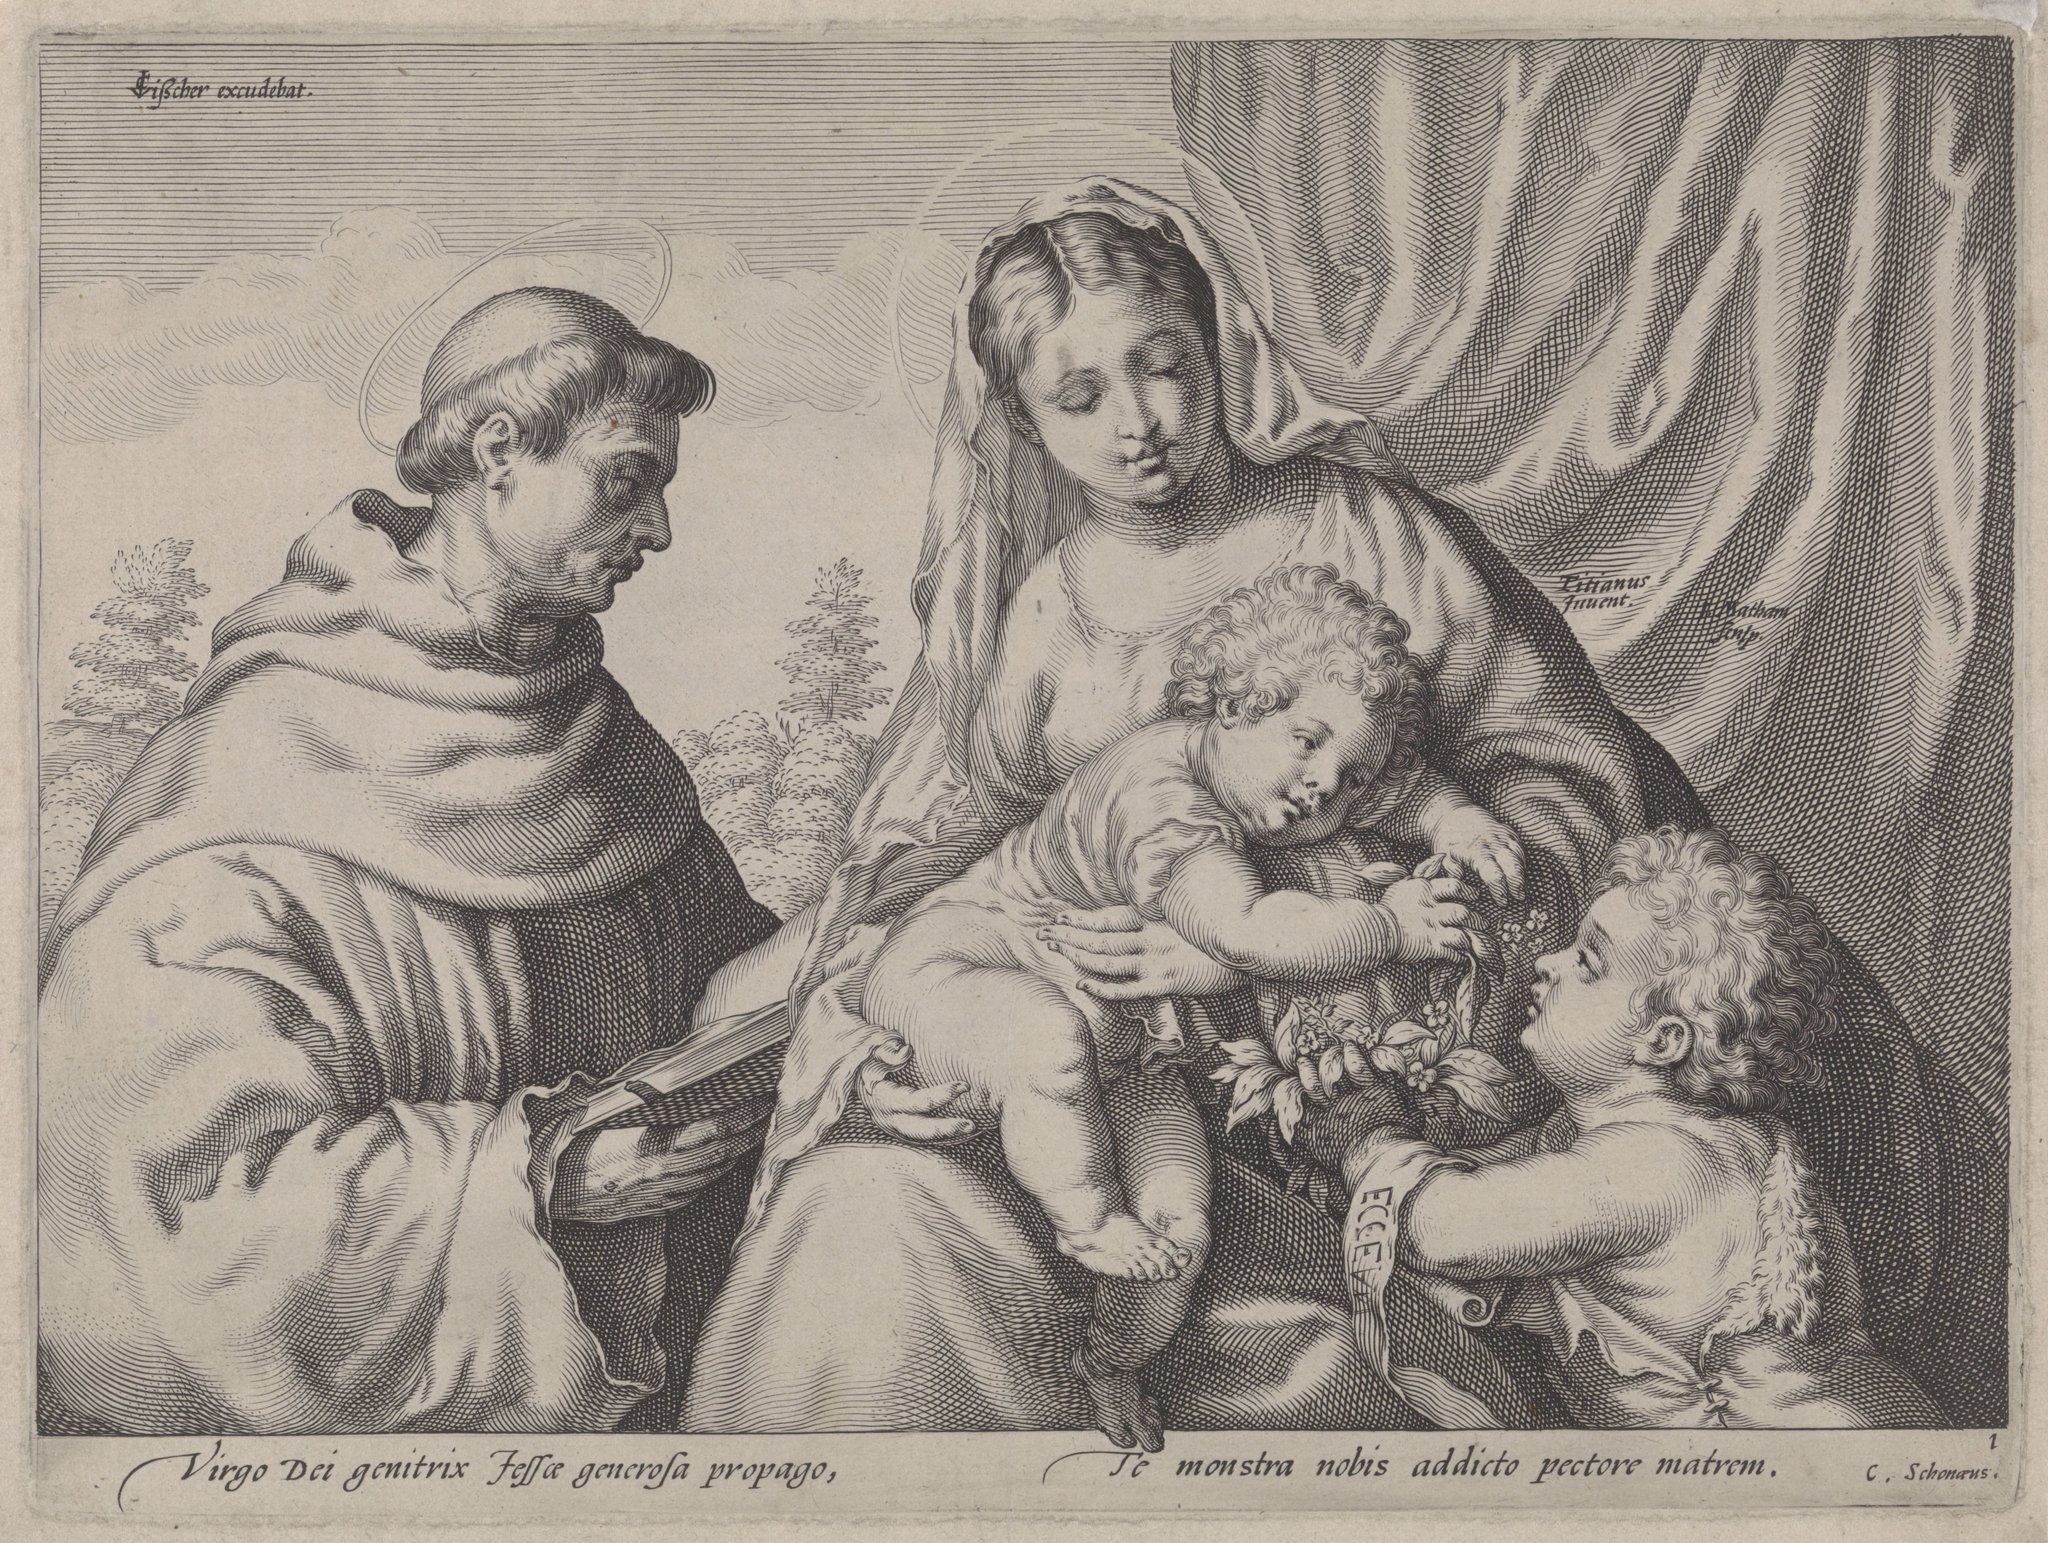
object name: print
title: Maria met Kind, Johannes de Doper en H. Franciscus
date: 1592-1596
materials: paper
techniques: engraving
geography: amsterdam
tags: adoration of the christ-child by mary; john the baptist present, madonna accompanied by saint(s), founder of the order of friars minor (franciscans), francis(cus) of assisi; possible attributes: book, crucifix, lily, skull, stigmata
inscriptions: collector's mark: Lugt 2228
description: Maria met het Christuskind op schoot. Johannes de Doper als kind biedt viooltjes aan. Naast hen staat de heilige Franciscus.